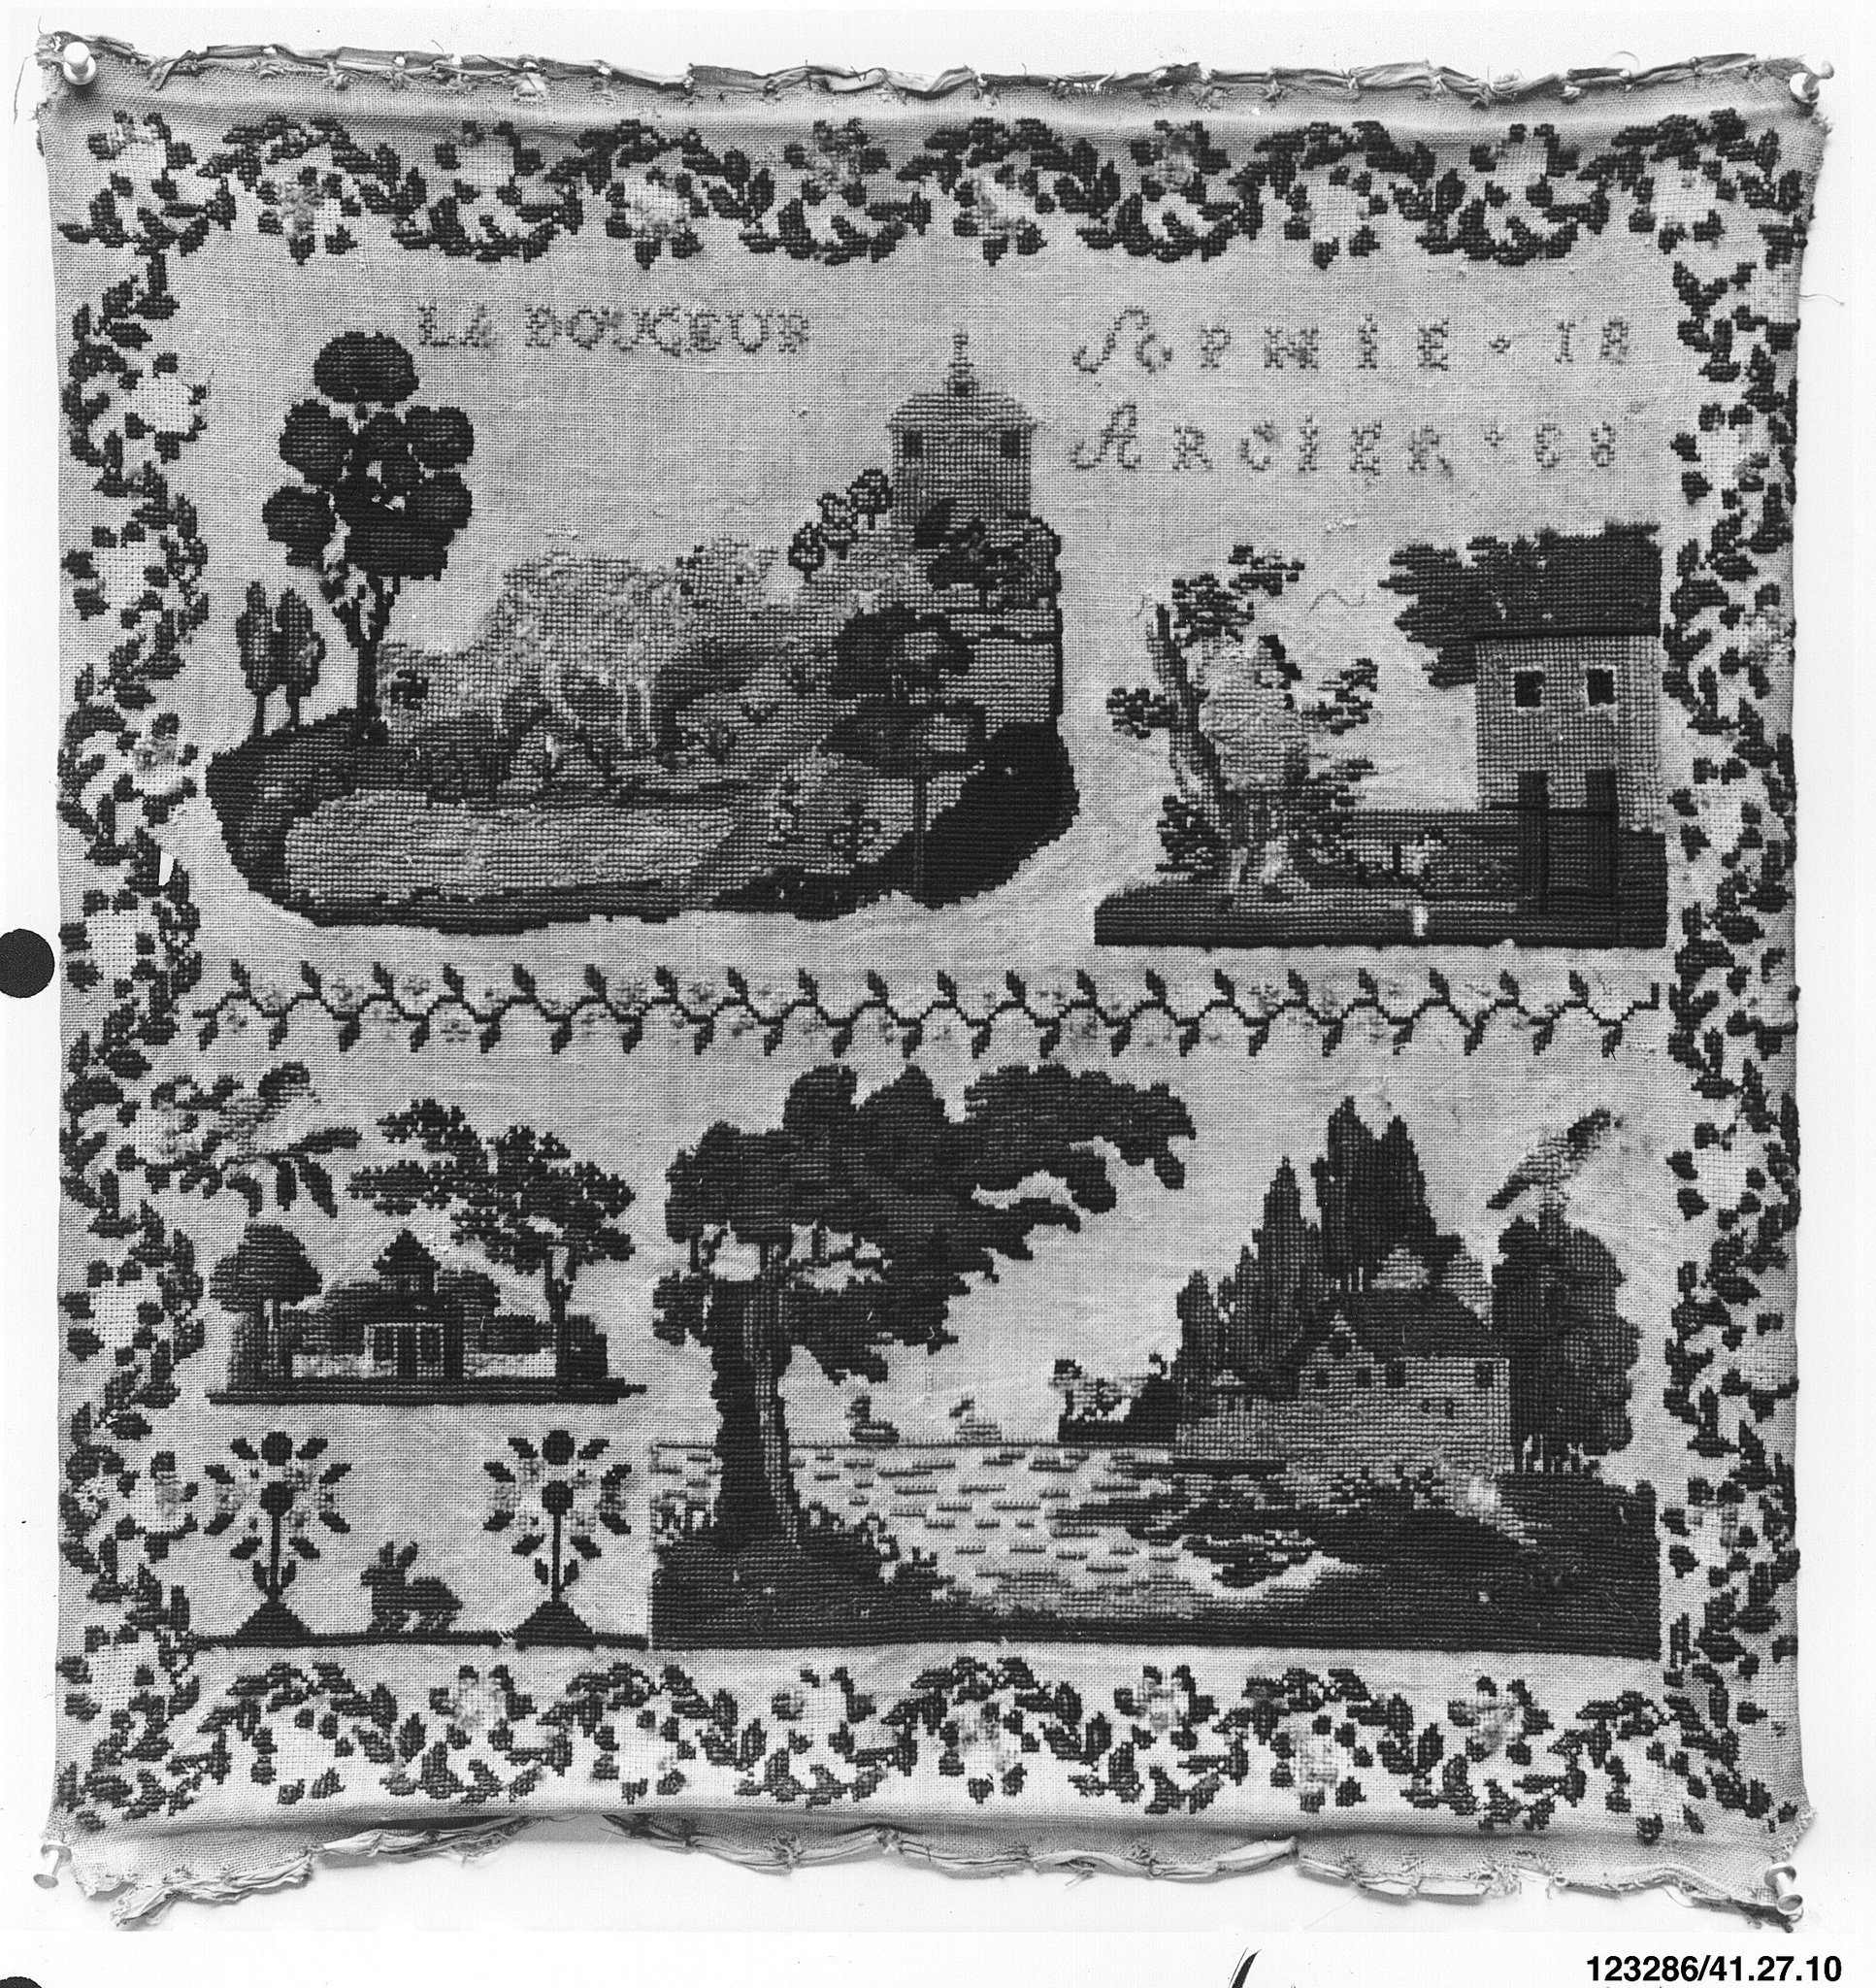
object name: sampler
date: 1888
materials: canvas, wool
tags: houses,trees